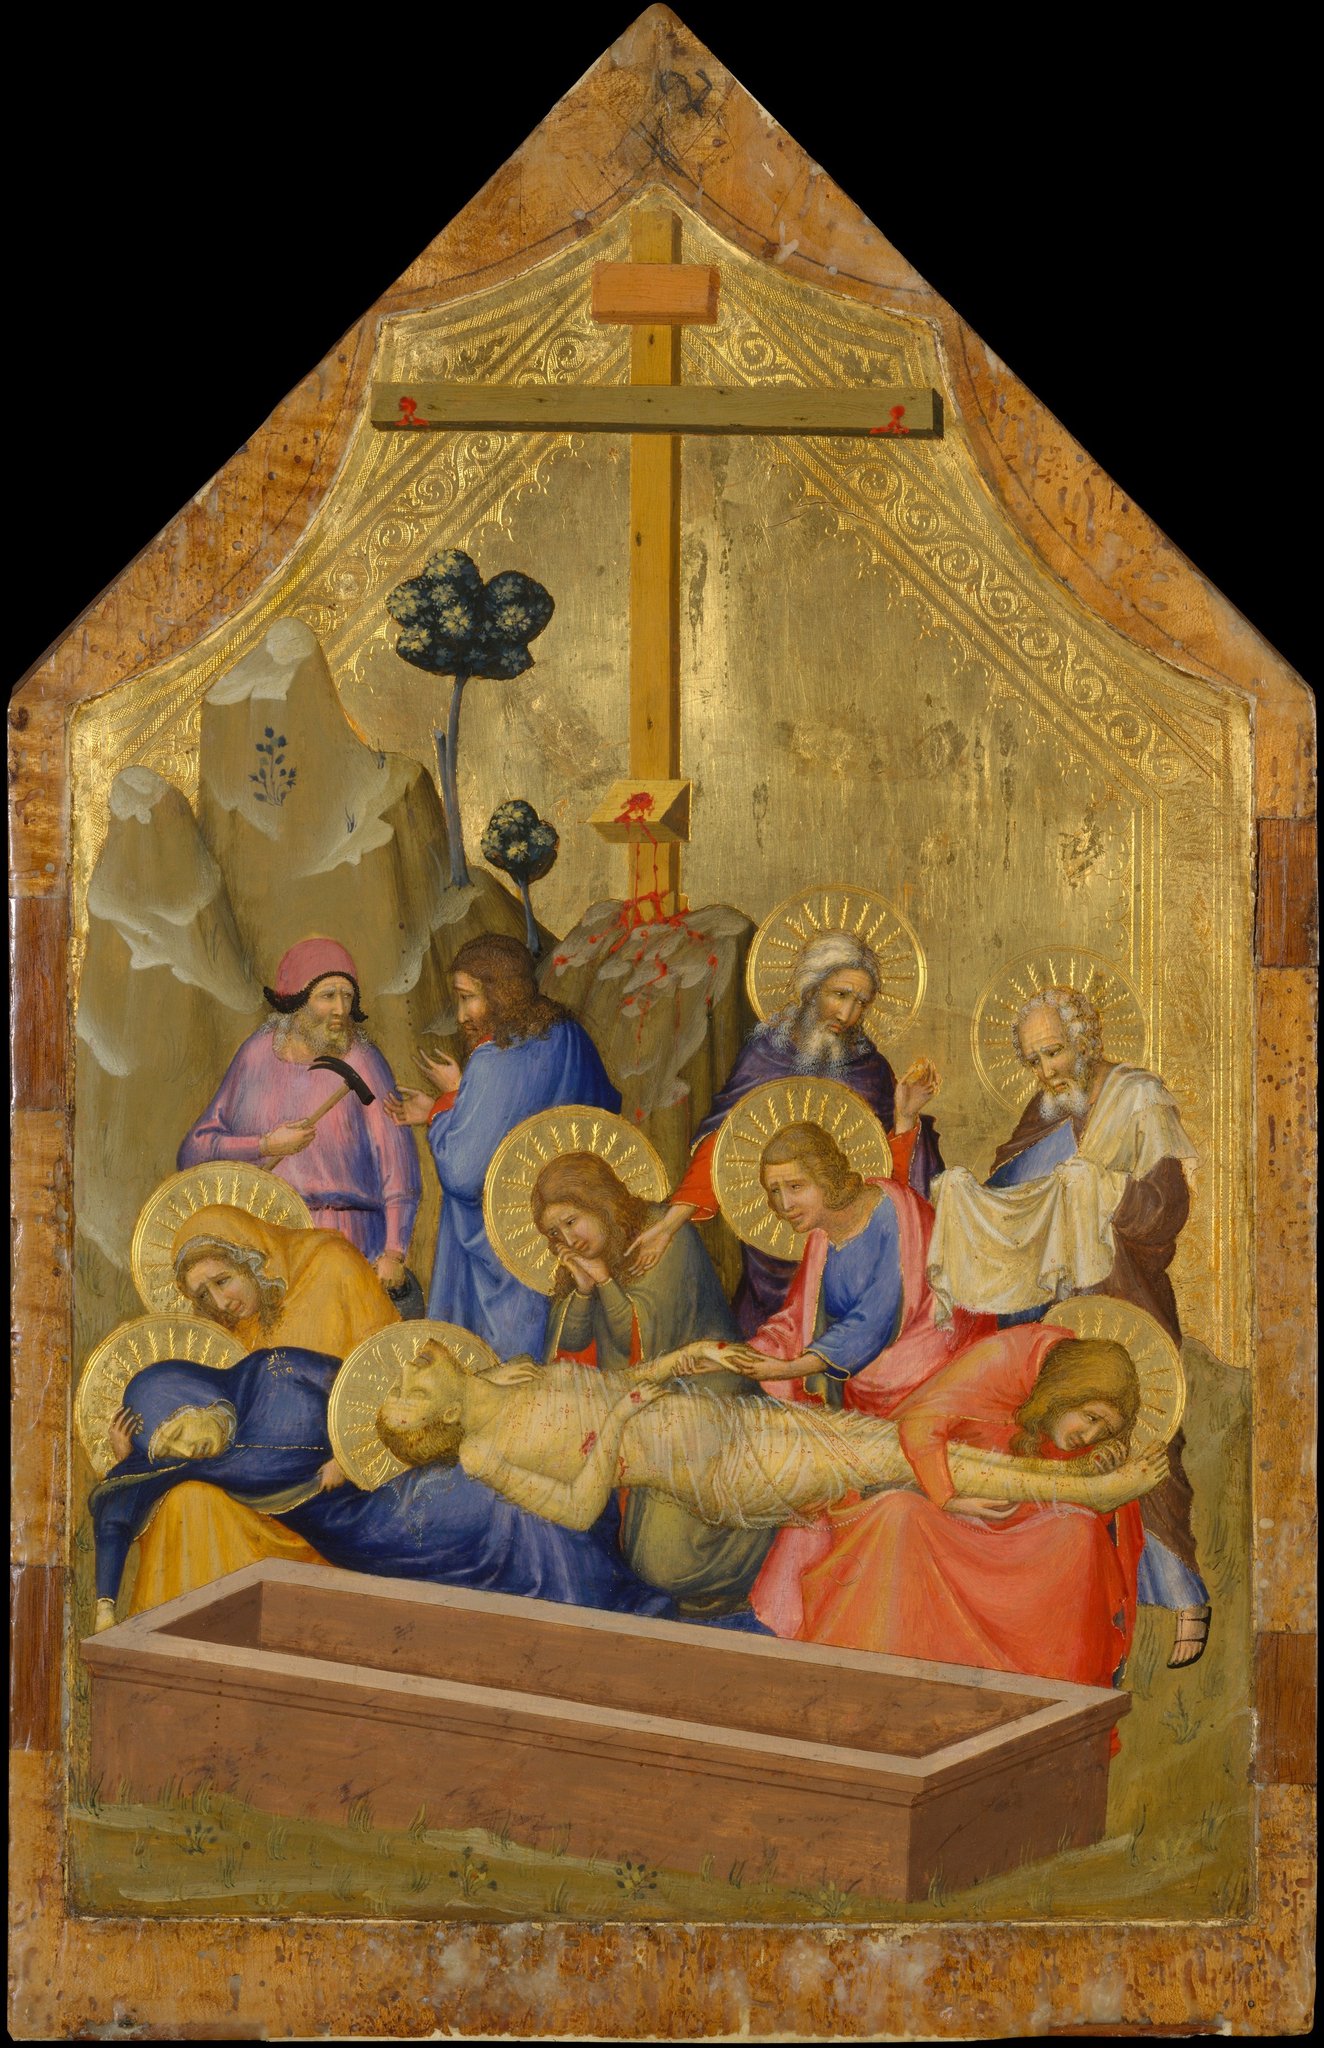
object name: painting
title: The Lamentation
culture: italian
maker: master of the codex of saint george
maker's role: artist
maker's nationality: italian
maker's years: 1310-1335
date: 1330-1335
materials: gold leaf, paint, wood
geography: france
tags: christ,mary magdalene,saint john the evangelist,virgin mary,lamentation,saints